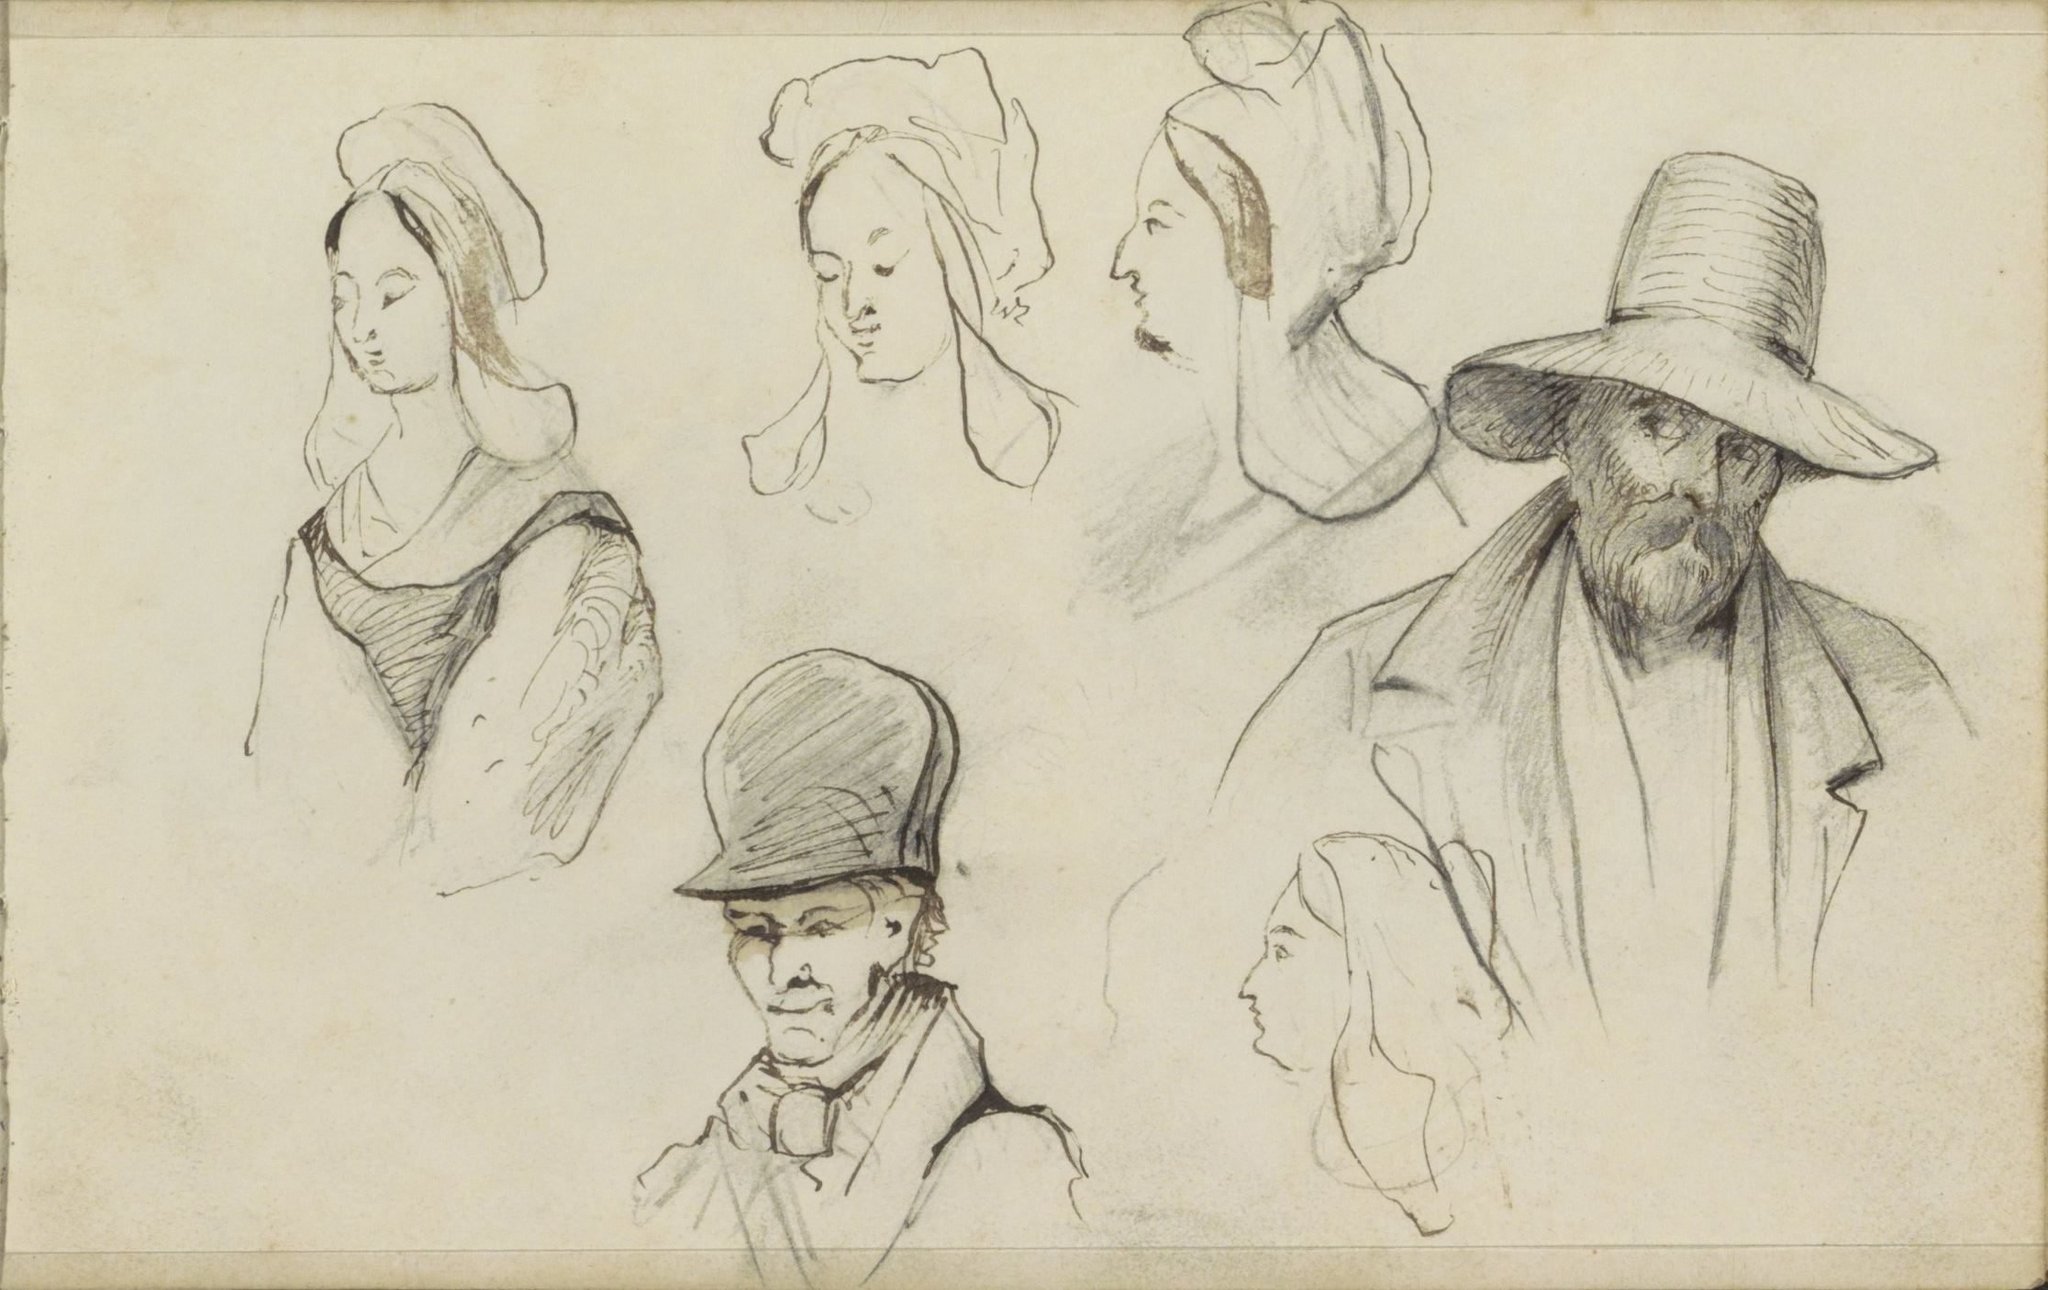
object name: sketchbook leaf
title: Mannen- en vrouwenkoppen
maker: johannes tavenraat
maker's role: draughtsman, painter, print maker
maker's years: 1809-1881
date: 1839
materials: paper, pencil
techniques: pen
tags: head (human), adult woman, head-gear, adult man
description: Blad 19 recto uit een schetsboek met 37 bladen.